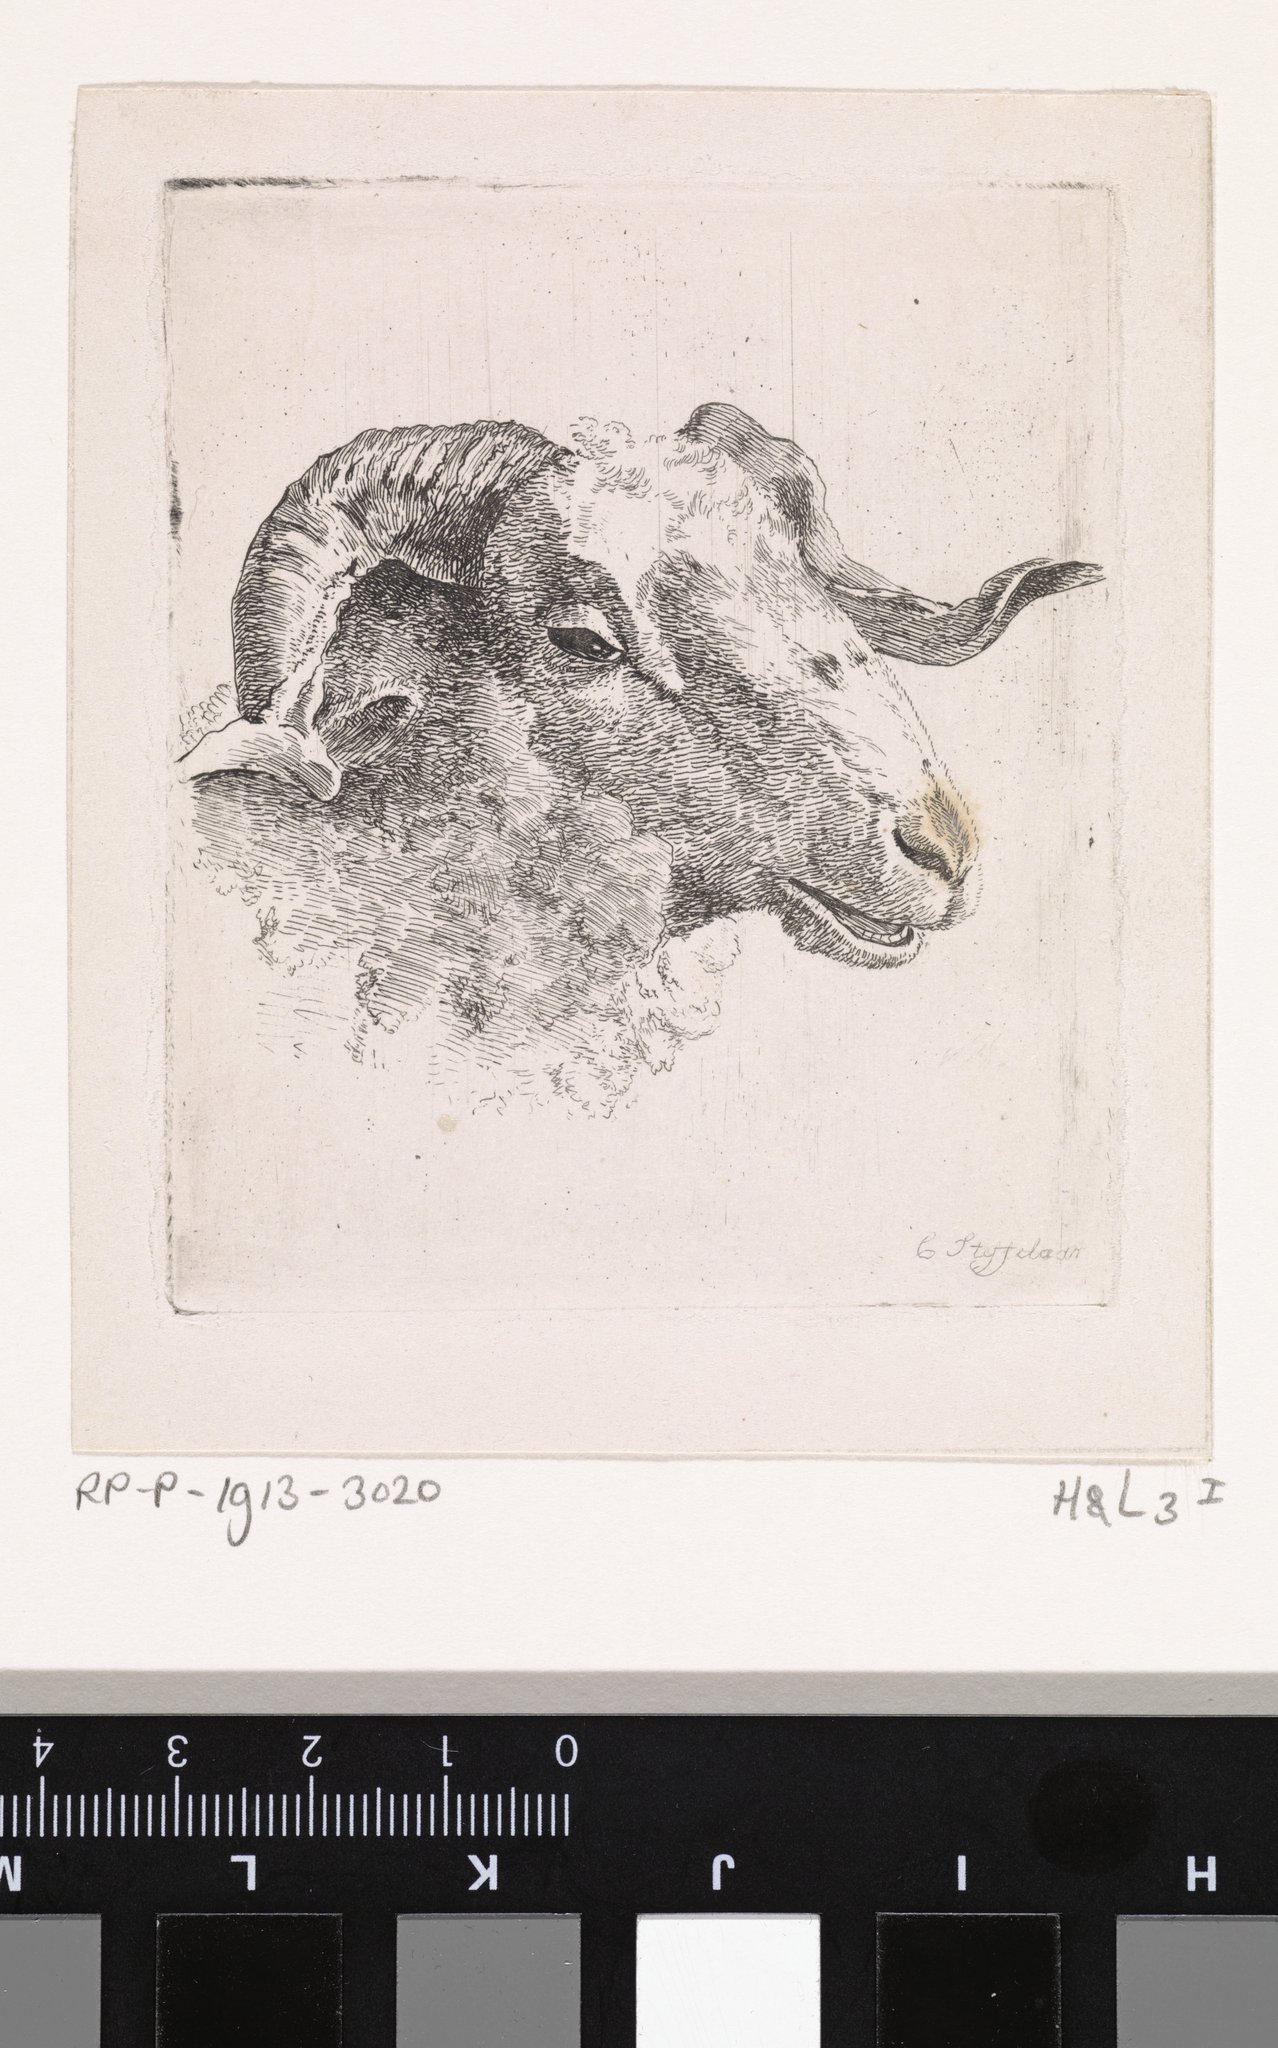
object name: print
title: Eerste suite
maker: cornelis steffelaar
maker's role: draughtsman, painter, print maker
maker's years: 1797-1861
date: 1807-1861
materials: paper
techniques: etching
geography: amsterdam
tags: ram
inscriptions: collector's mark: Lugt 2228